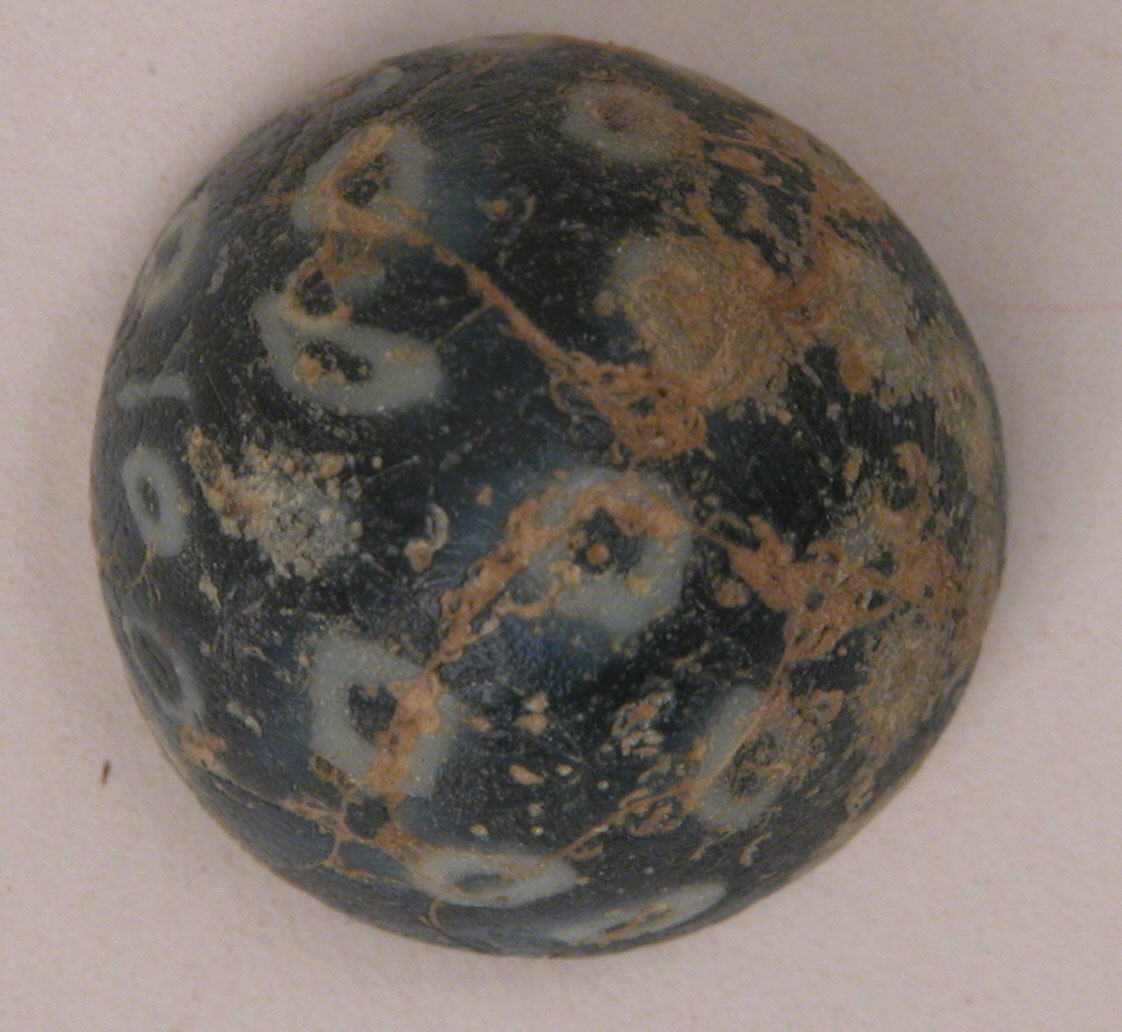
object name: gaming piece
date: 701-1200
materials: glass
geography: islamic lands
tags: games